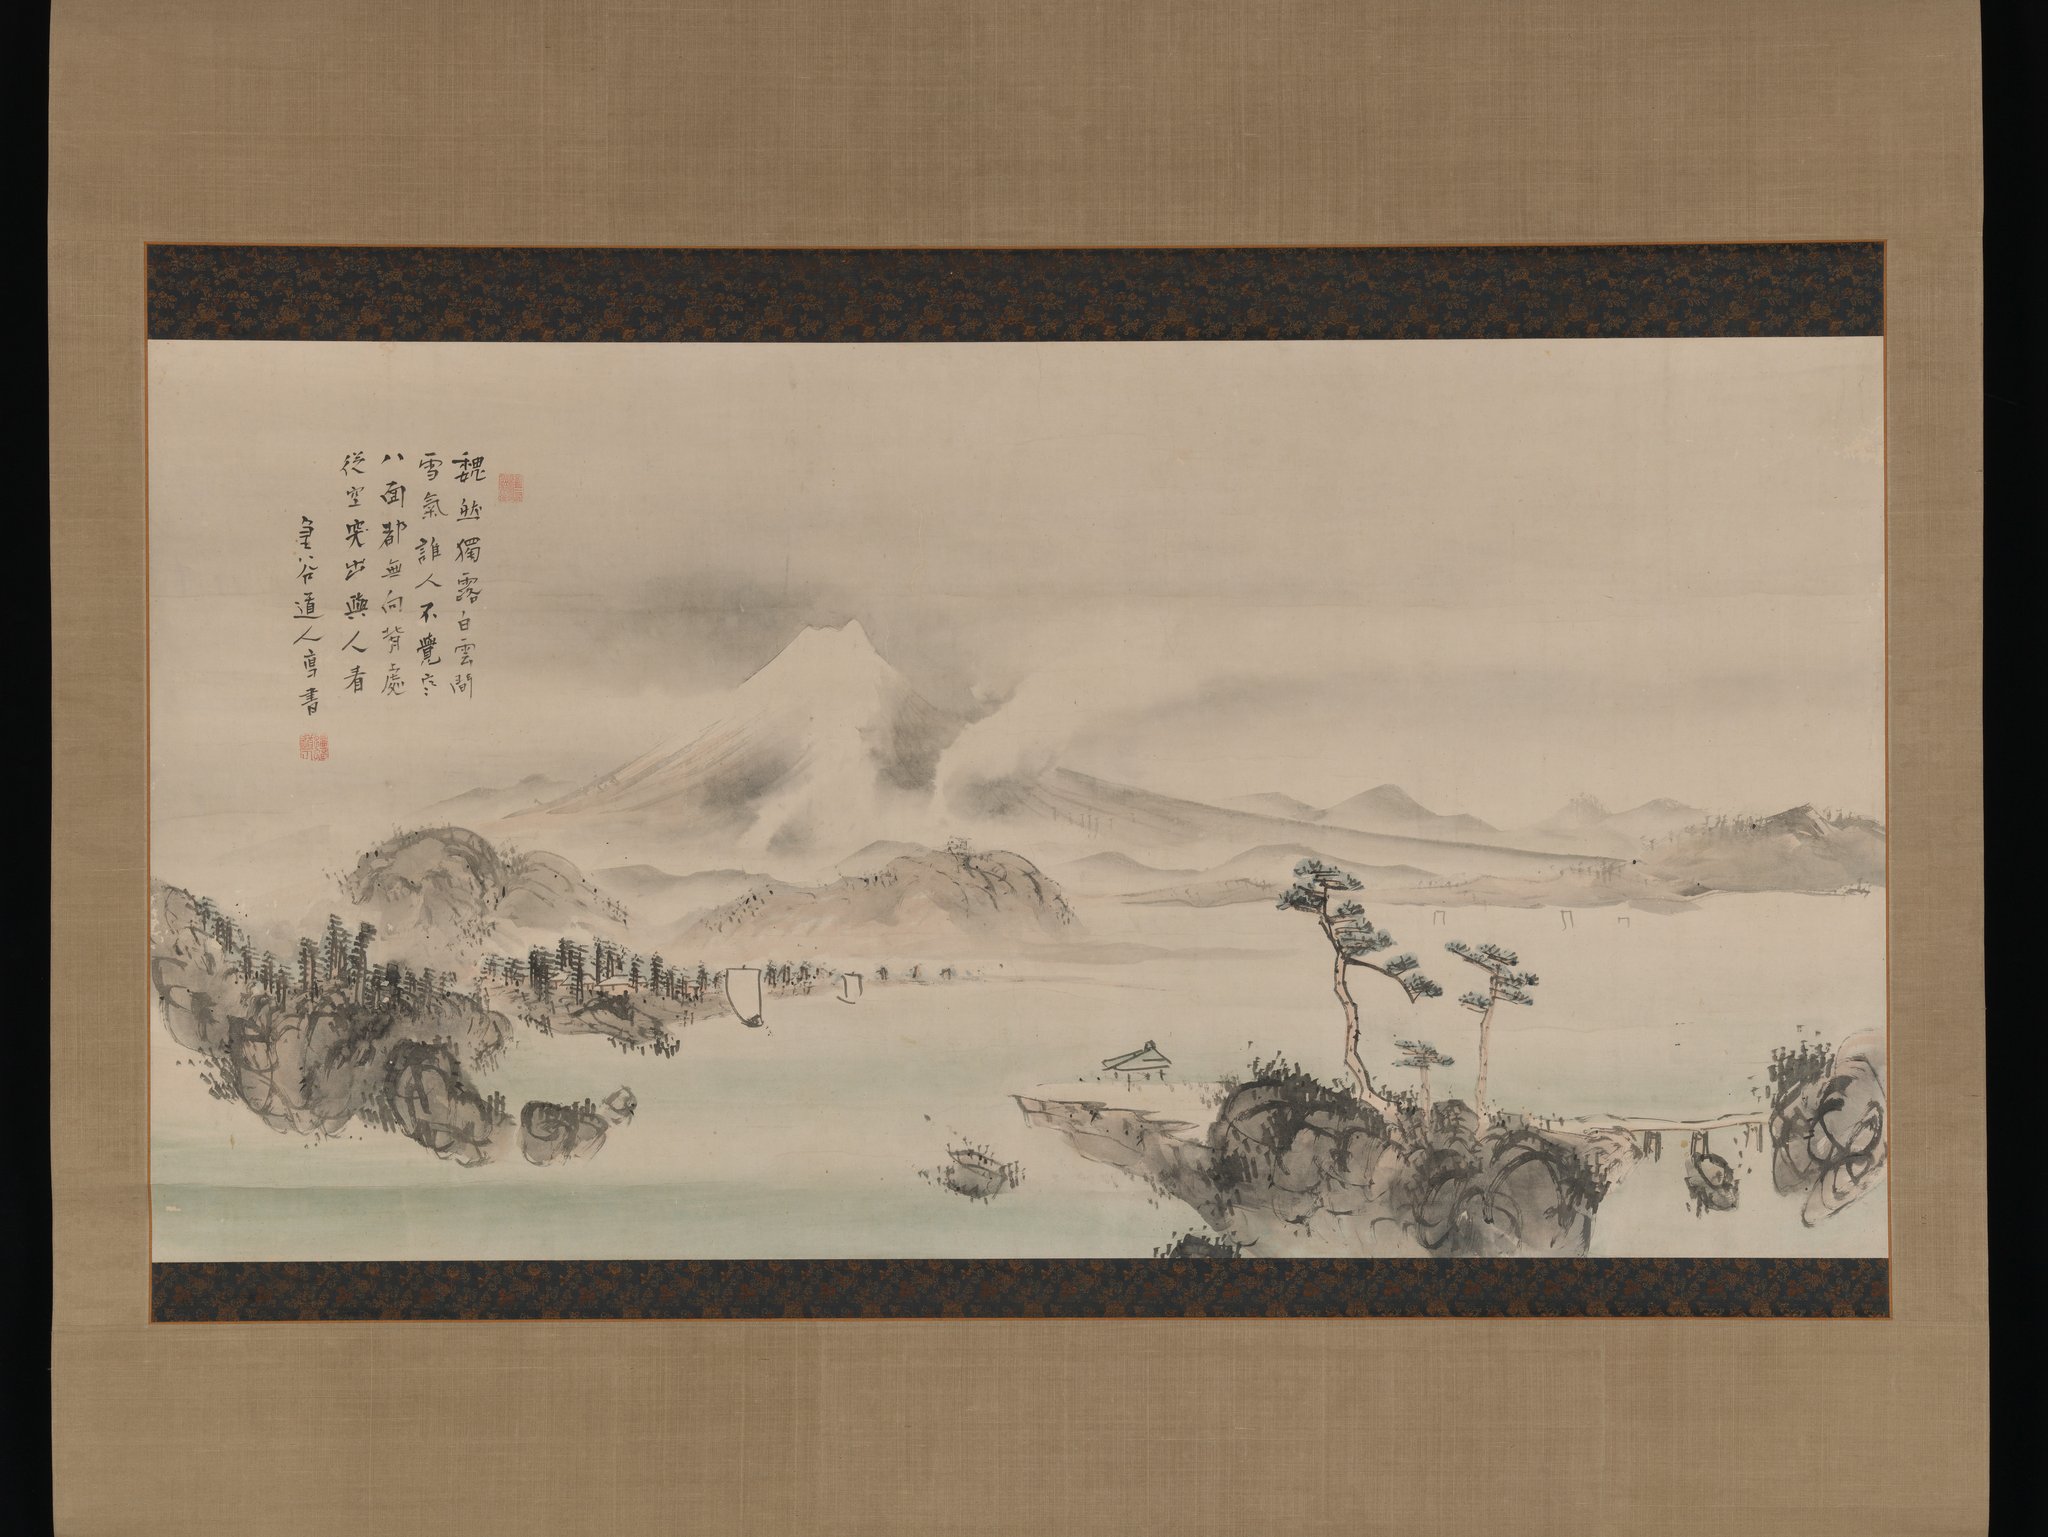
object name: hanging scroll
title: Mount Fuji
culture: japanese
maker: yokoi kinkoku 横井金谷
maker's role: artist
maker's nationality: japanese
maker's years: 1761-1832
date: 1801-1833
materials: ink, paper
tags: mountains,landscapes